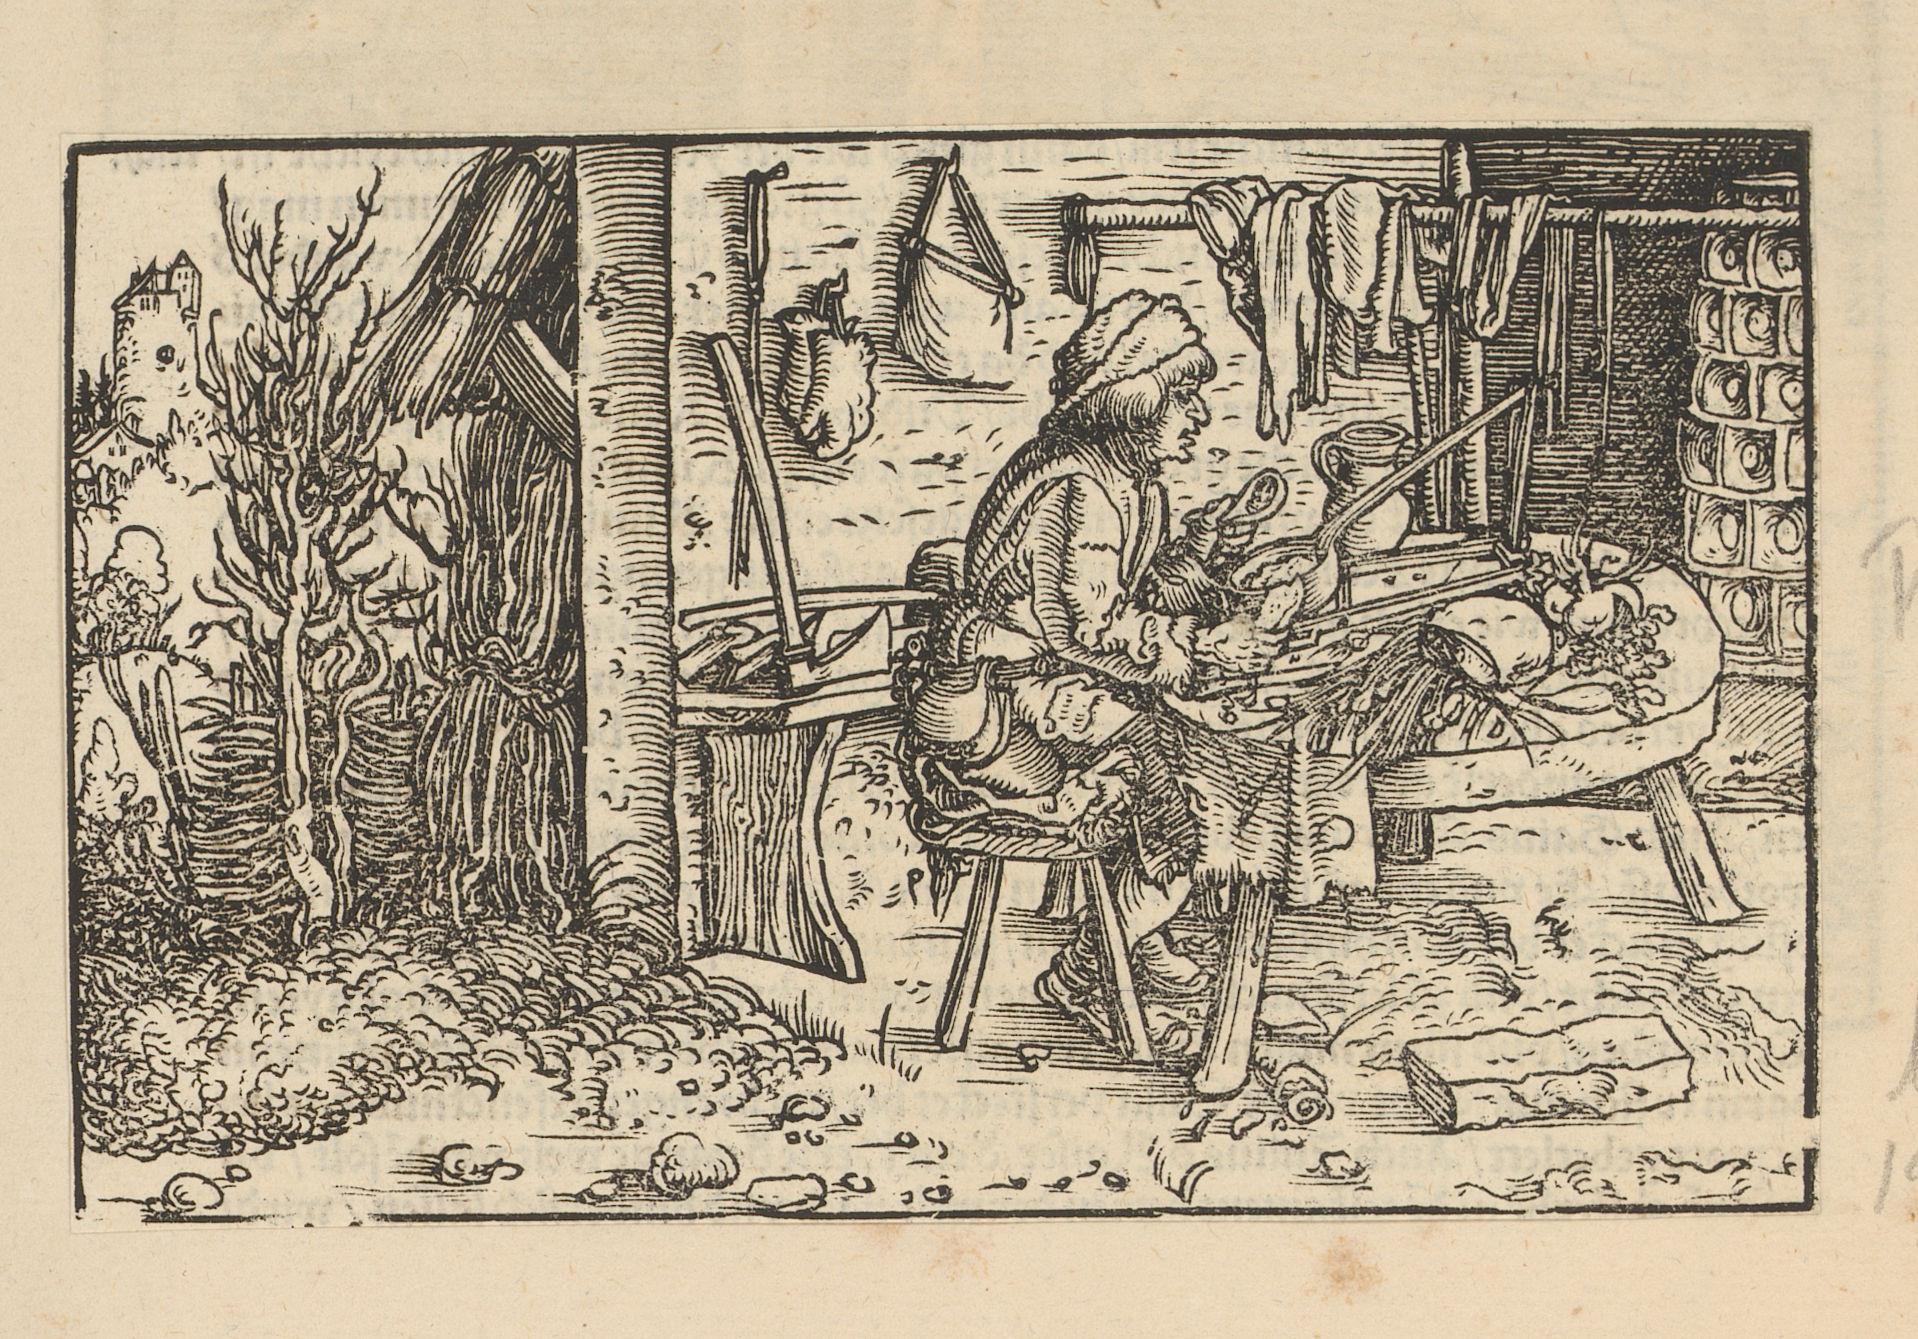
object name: album leaf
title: Arme man eet uit een pan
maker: Anonymous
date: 1514-1532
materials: paper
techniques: letterpress printing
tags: eating, the poor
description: Deze prent is gebruikt in: Petrarca, Francesco. Von der Artzney bayder Glück, des guten und widerwertigen: unnd weß sich ain yeder inn Gelück und Unglück halten sol (...). Augsburg: Heinrich Steiner, 1532. Deze uitgave is ook bekend onder de titel 'Trostspiegel in Glück und Unglück'.